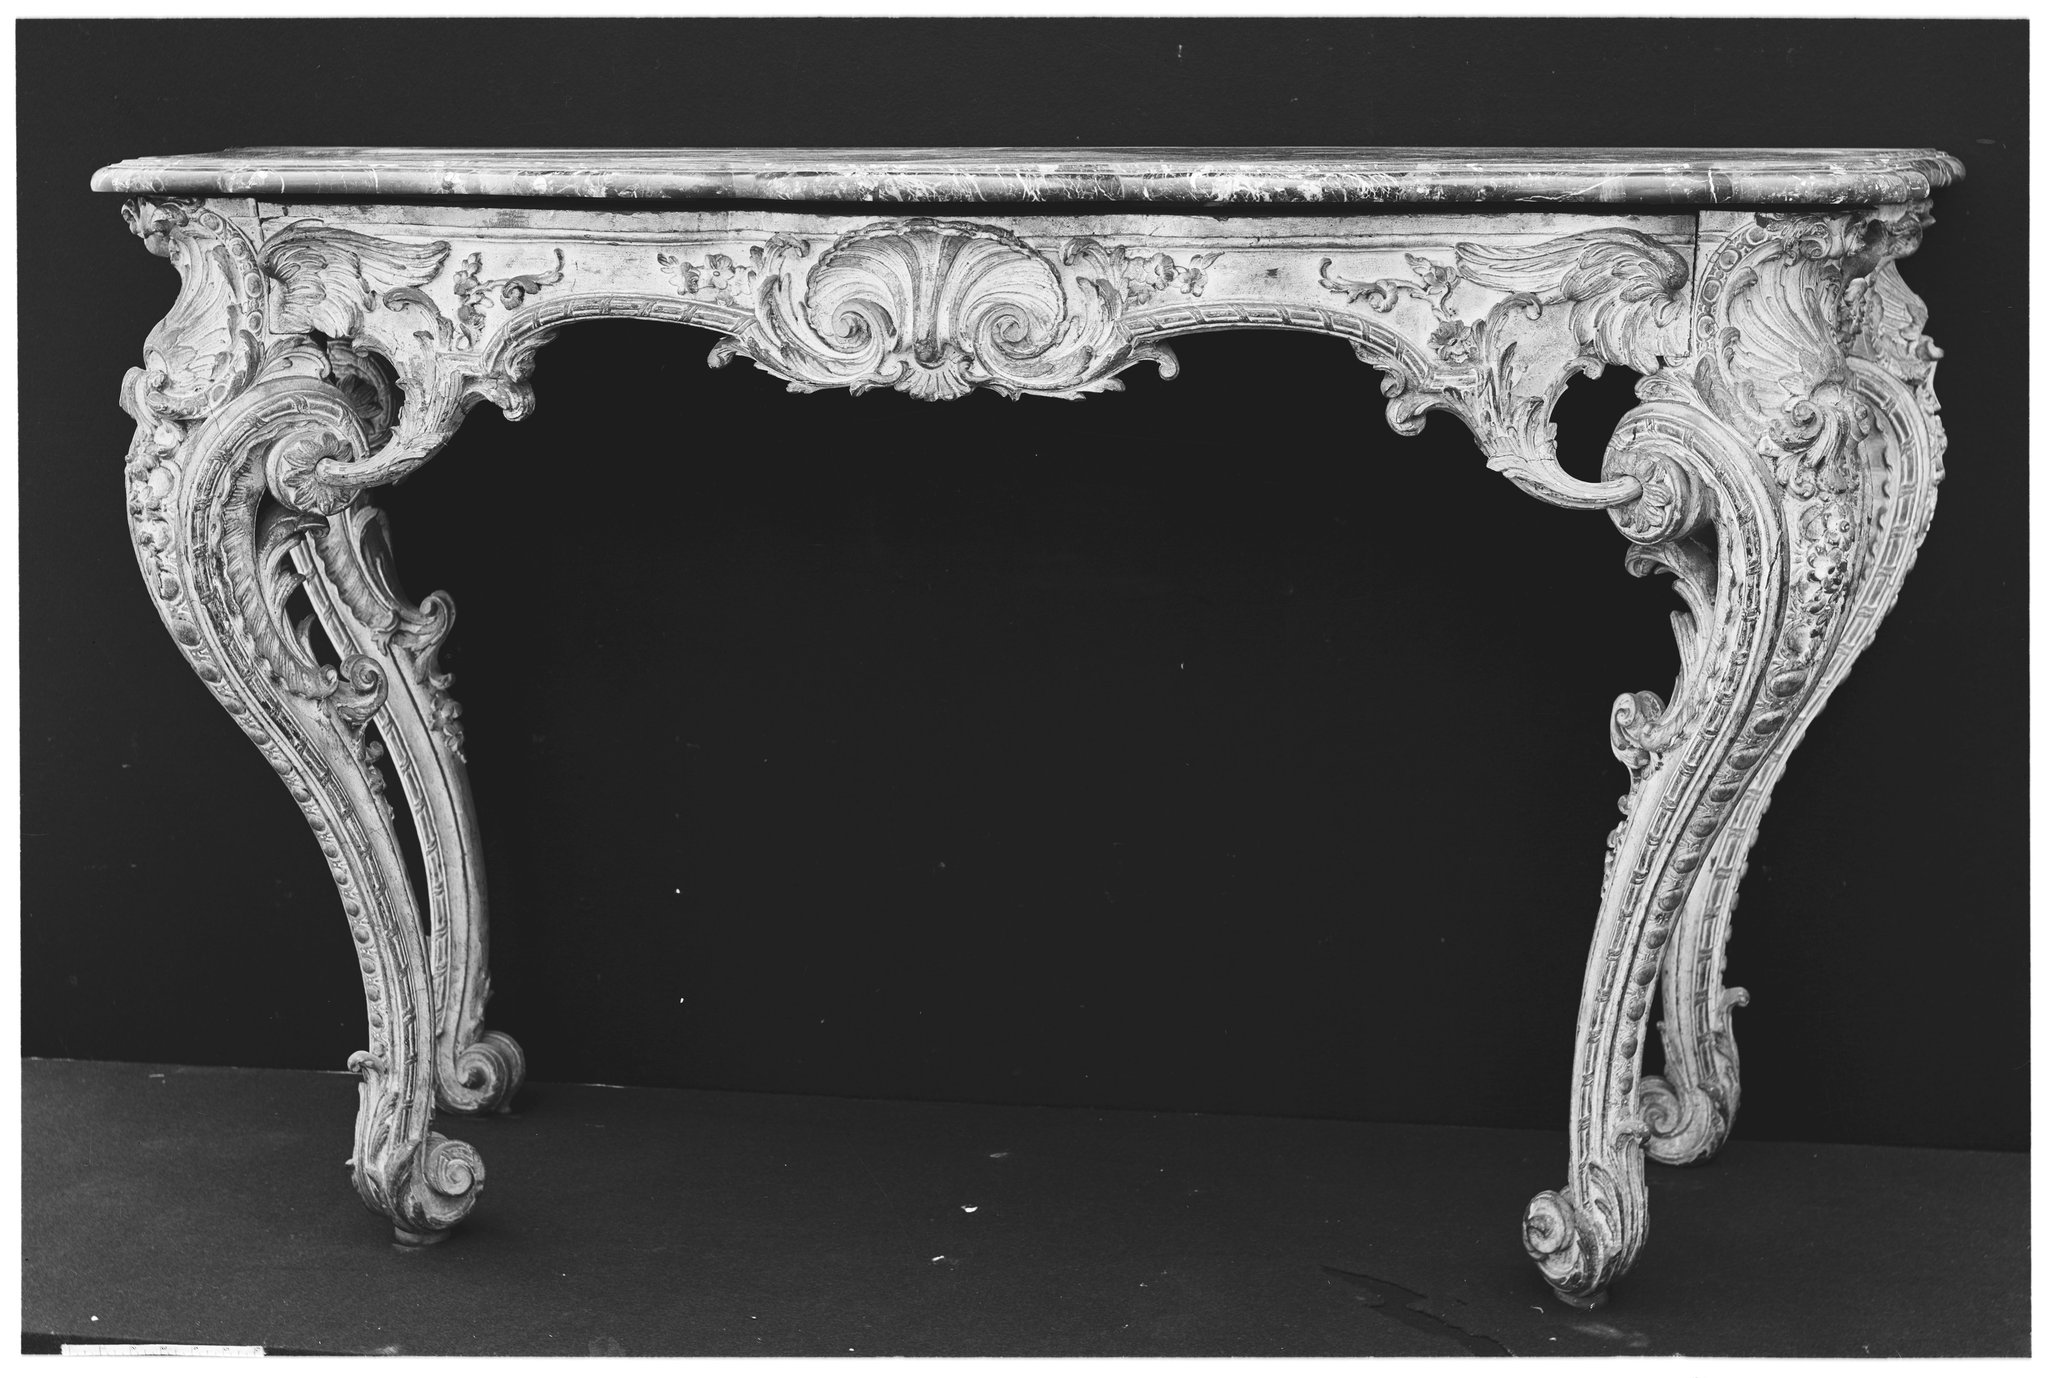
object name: table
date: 1725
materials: marble, wood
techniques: carving, painting